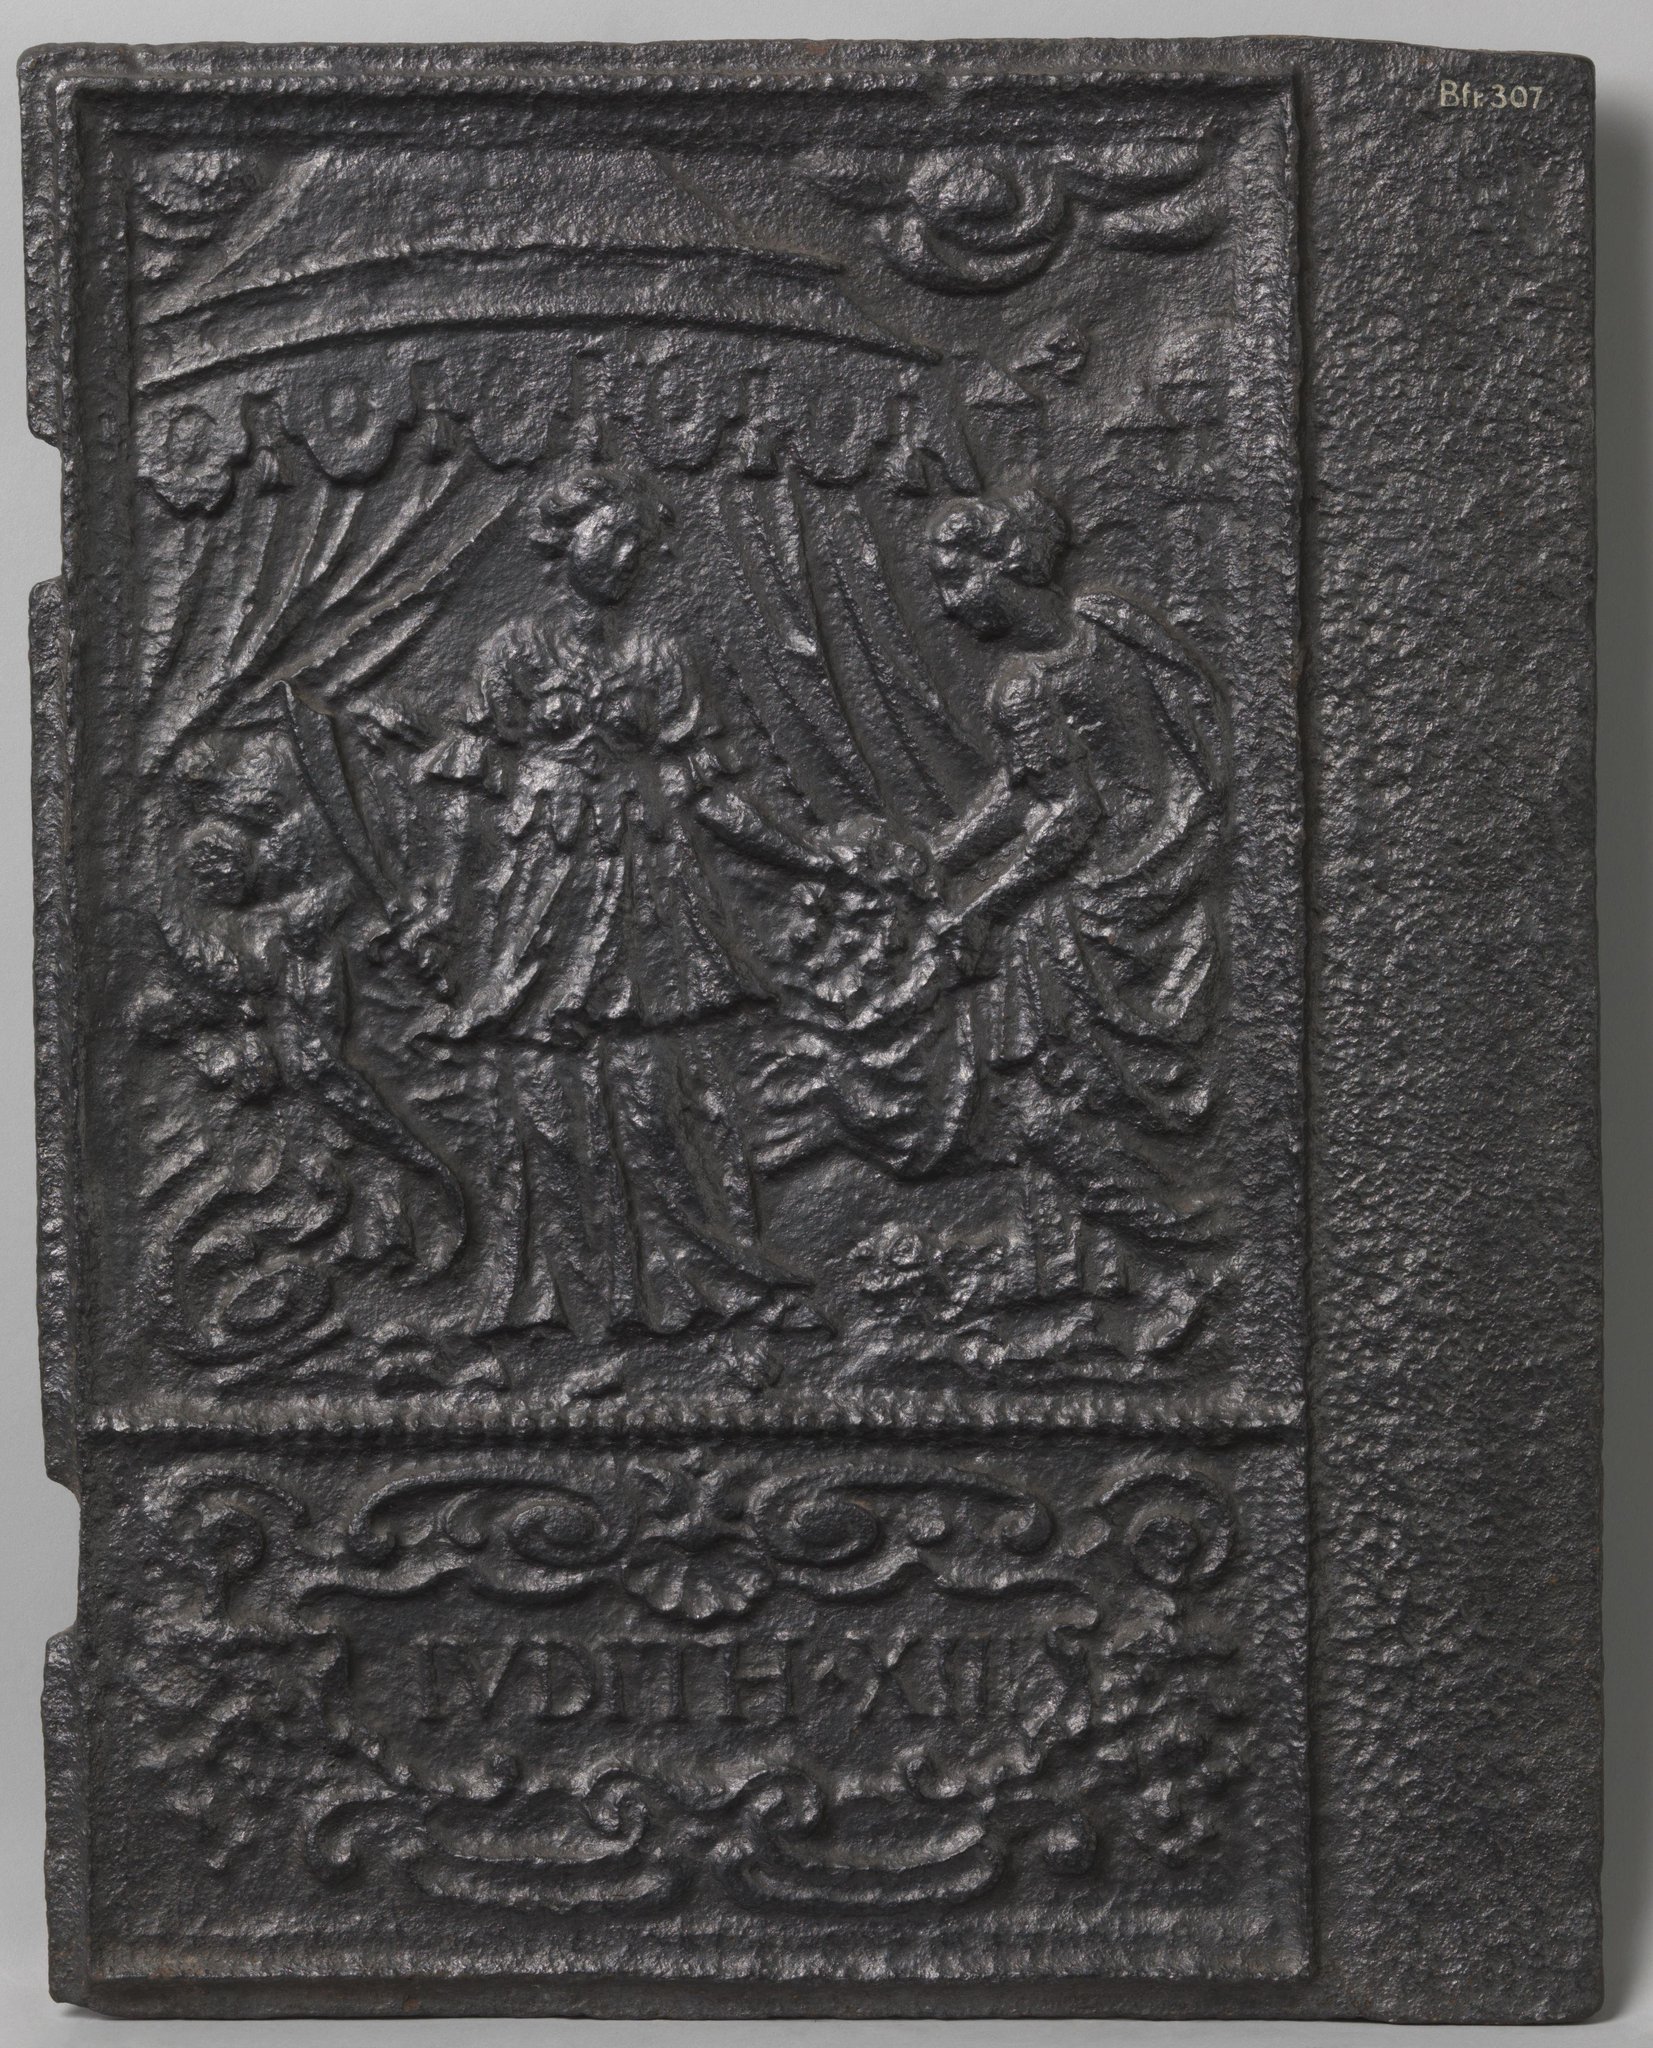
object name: stove plate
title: Kachelplaat met voorstelling van Judith met het hoofd van Holofernes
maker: Anonymous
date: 1600-1700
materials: iron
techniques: casting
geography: germany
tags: judith shows holofernes' head to the people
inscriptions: inscription: ‘IVDITH.XIII’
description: Kachelplaat van gietijzer. De voorstelling is verdeeld in twee zones. In de bovenste is een tent te zien met daarin Judith die het hoofd van Holofernes in een zak stopt. In de onderste zone staat in een cartouche IVDITH.XIII